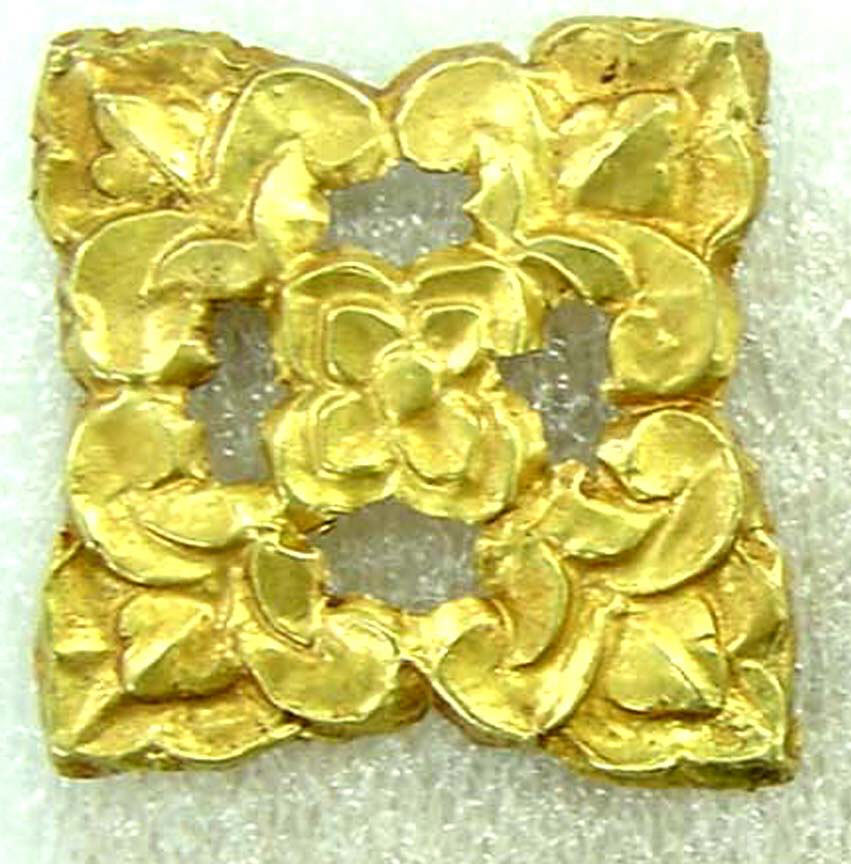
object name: plaque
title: Square Plaque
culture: northwest chinese or eastern central asian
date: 634-900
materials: gold